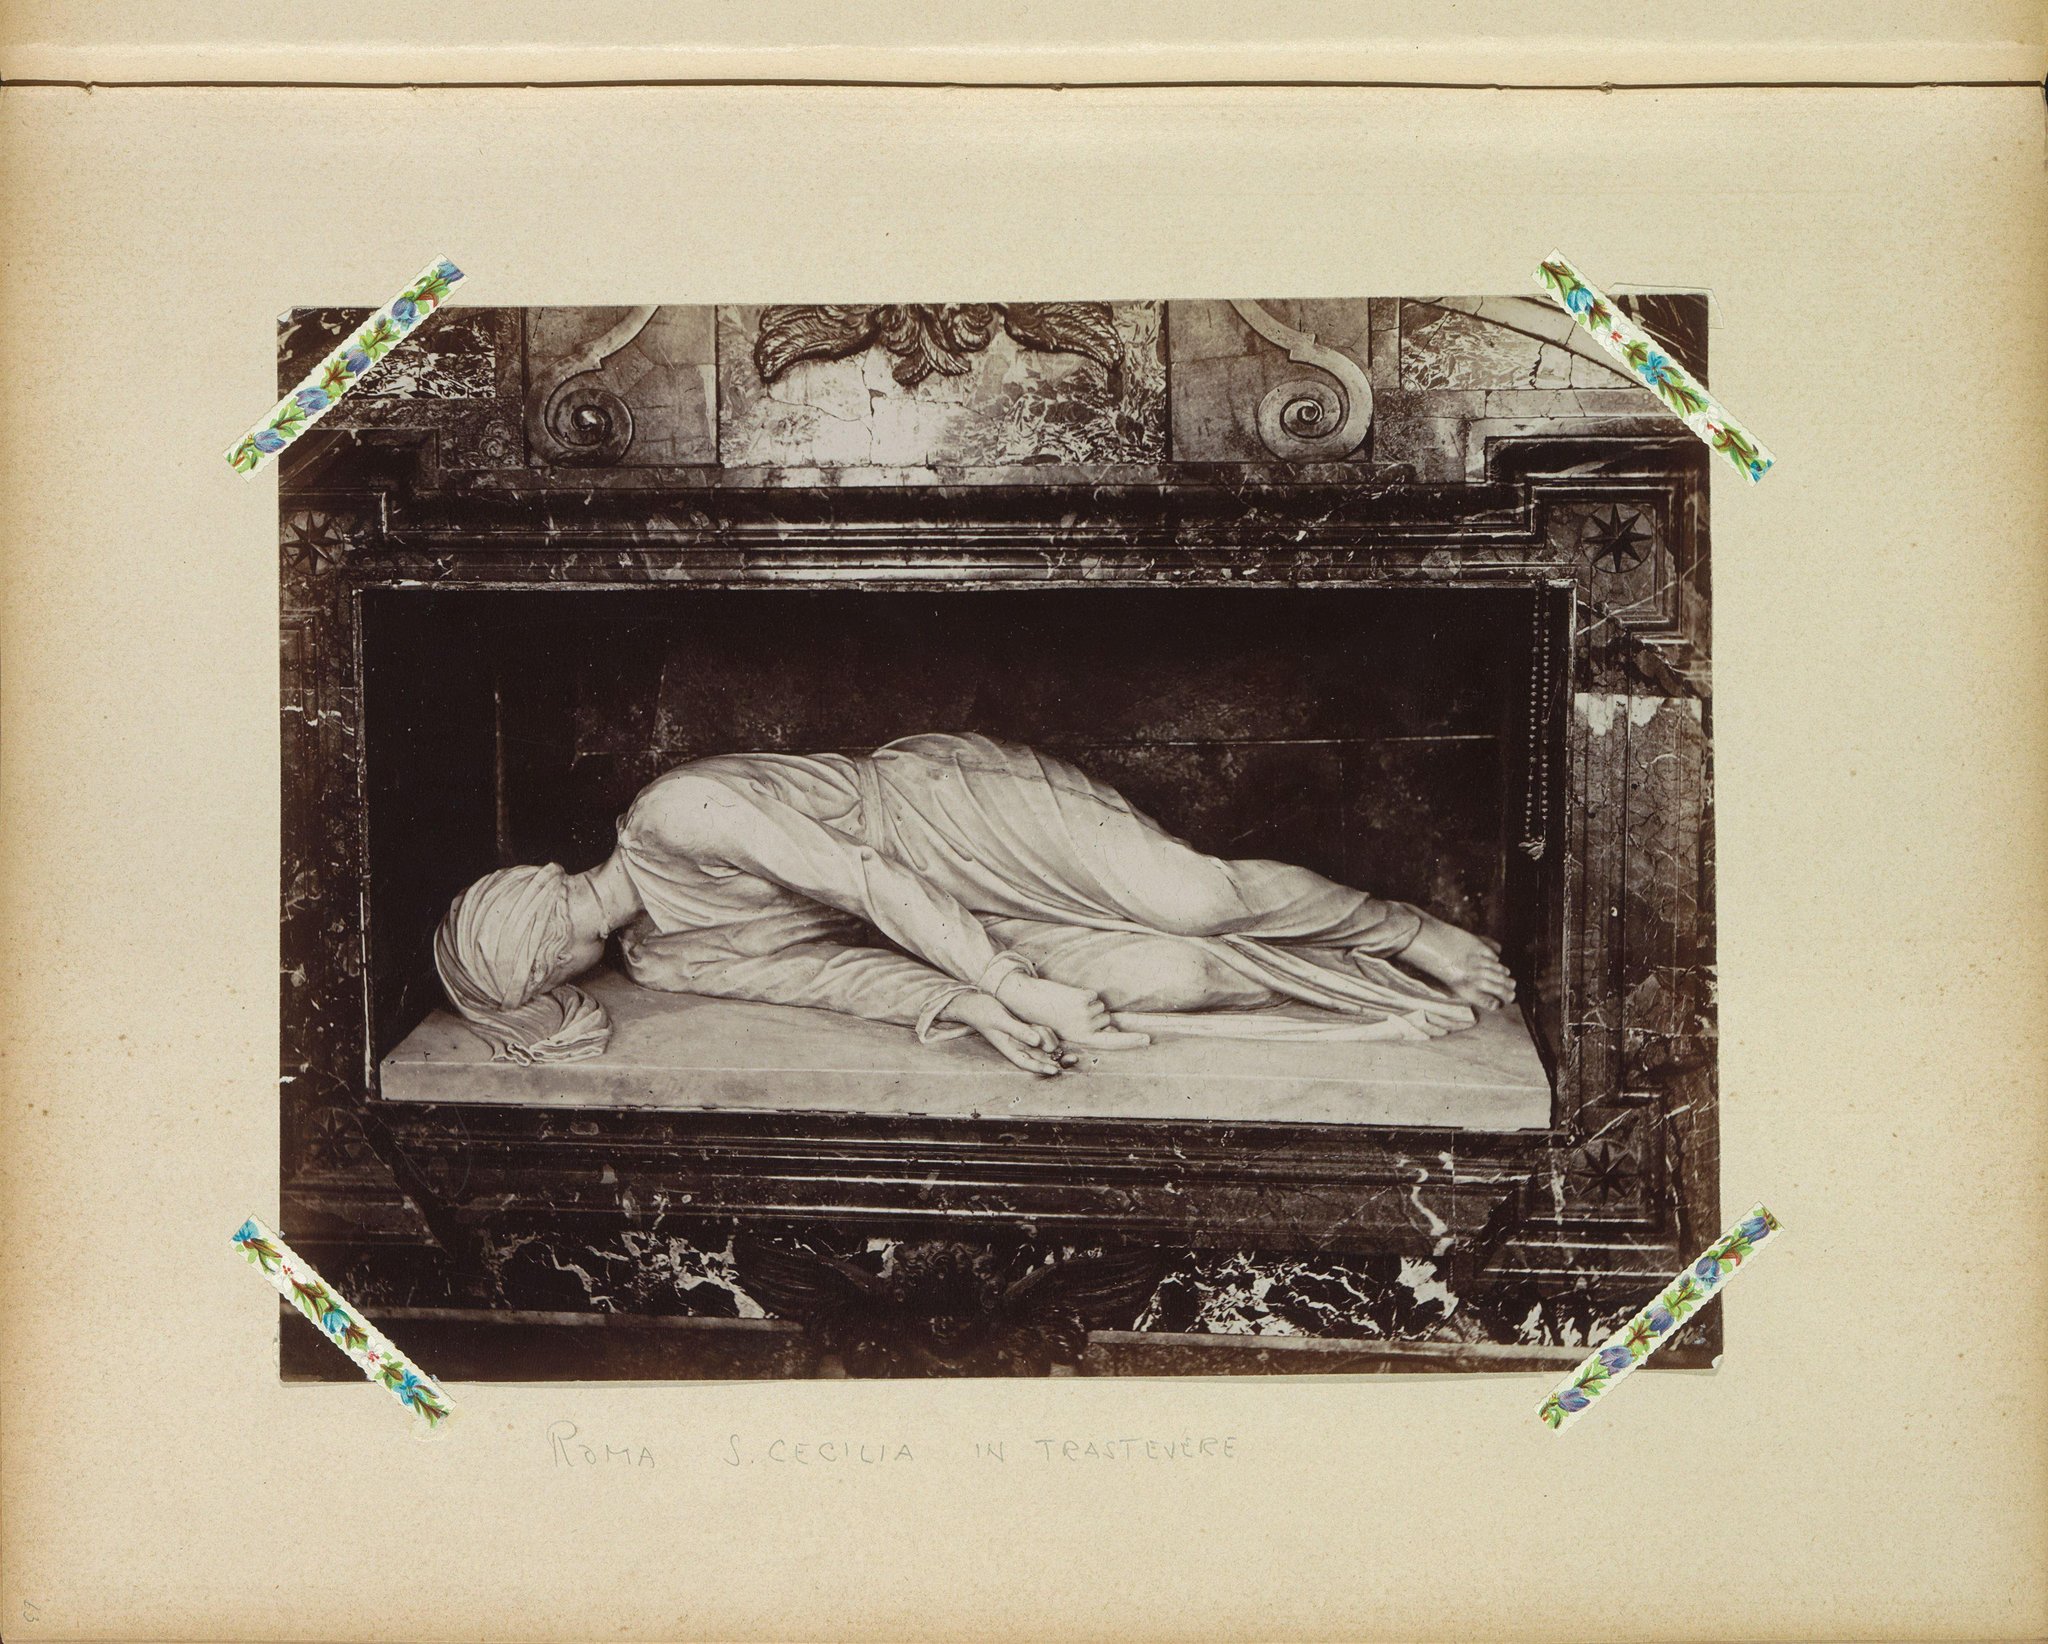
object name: photograph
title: Beeld van de heilige Cecilia in de basiliek van Santa Cecilia in Rome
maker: Anonymous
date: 1860-1900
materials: photographic support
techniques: albumen print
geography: rome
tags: death of cecilia: she lies down with three wounds in her neck, rome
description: Onderdeel van Fotoalbum met opnames van bezienswaardigheden in Italiaanse steden en van kunstwerken.